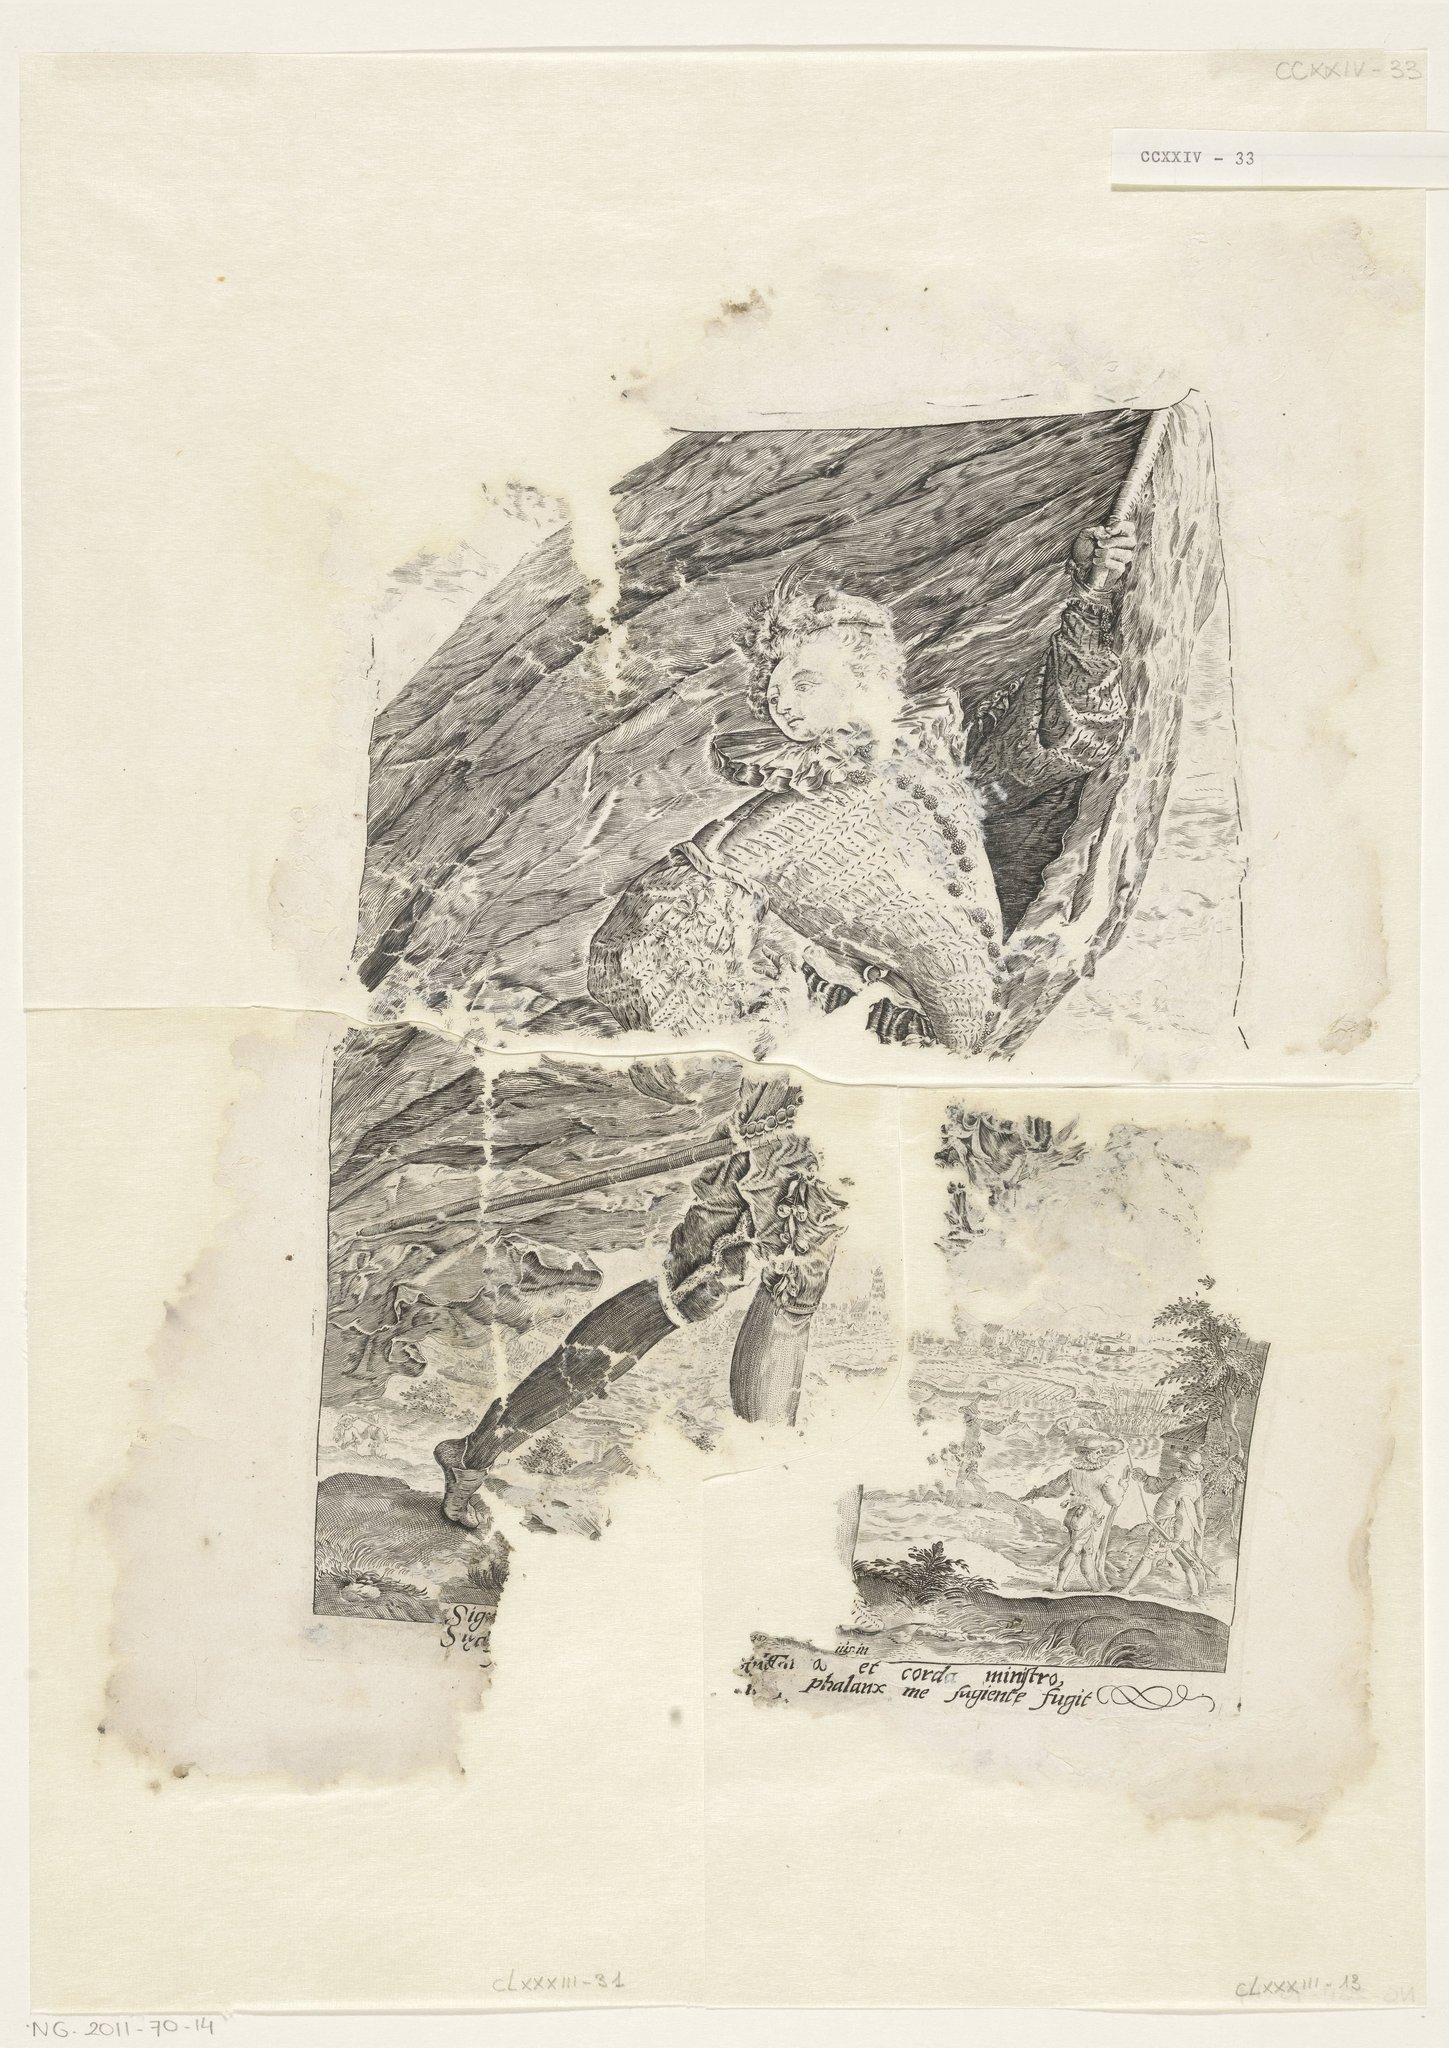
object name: print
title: Vaandeldrager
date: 1587-1596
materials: paper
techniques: engraving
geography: northern netherlands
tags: (military) standard-bearer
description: De prenten in de Nova Zembla collectie zijn tijdens een expeditie van Willem Barendsz en Jacob van Heemskerk in 1596-1597 noodgedwongen in het winterkamp, het ‘Behouden Huis’, op het eiland achtergelaten. De prenten waren in één of meerdere stapels als handelswaar meegenomen vanuit Amsterdam. Bijna drie eeuwen later, in 1871, keerde de Noor Elling Carlsen terug naar Nova Zembla en vond daar de restanten van het ‘Behouden Huis, inclusief een groot deel van de inventaris. Een deel van de prenten, in de vorm van aaneengekoekte kluiten, werd toen ook teruggevonden. De papierkluiten waren soms op meerdere plekken gebroken. Tussen 1975-1979 zijn de prenten van elkaar gescheiden. Dit leverde in totaal ca. 1000 fragmenten van ca. 400 afdrukken van ca. 150 verschillende prenten op. Voor zover mogelijk zijn de fragmenten samengevoegd en zijn de prenten gereconstrueerd.